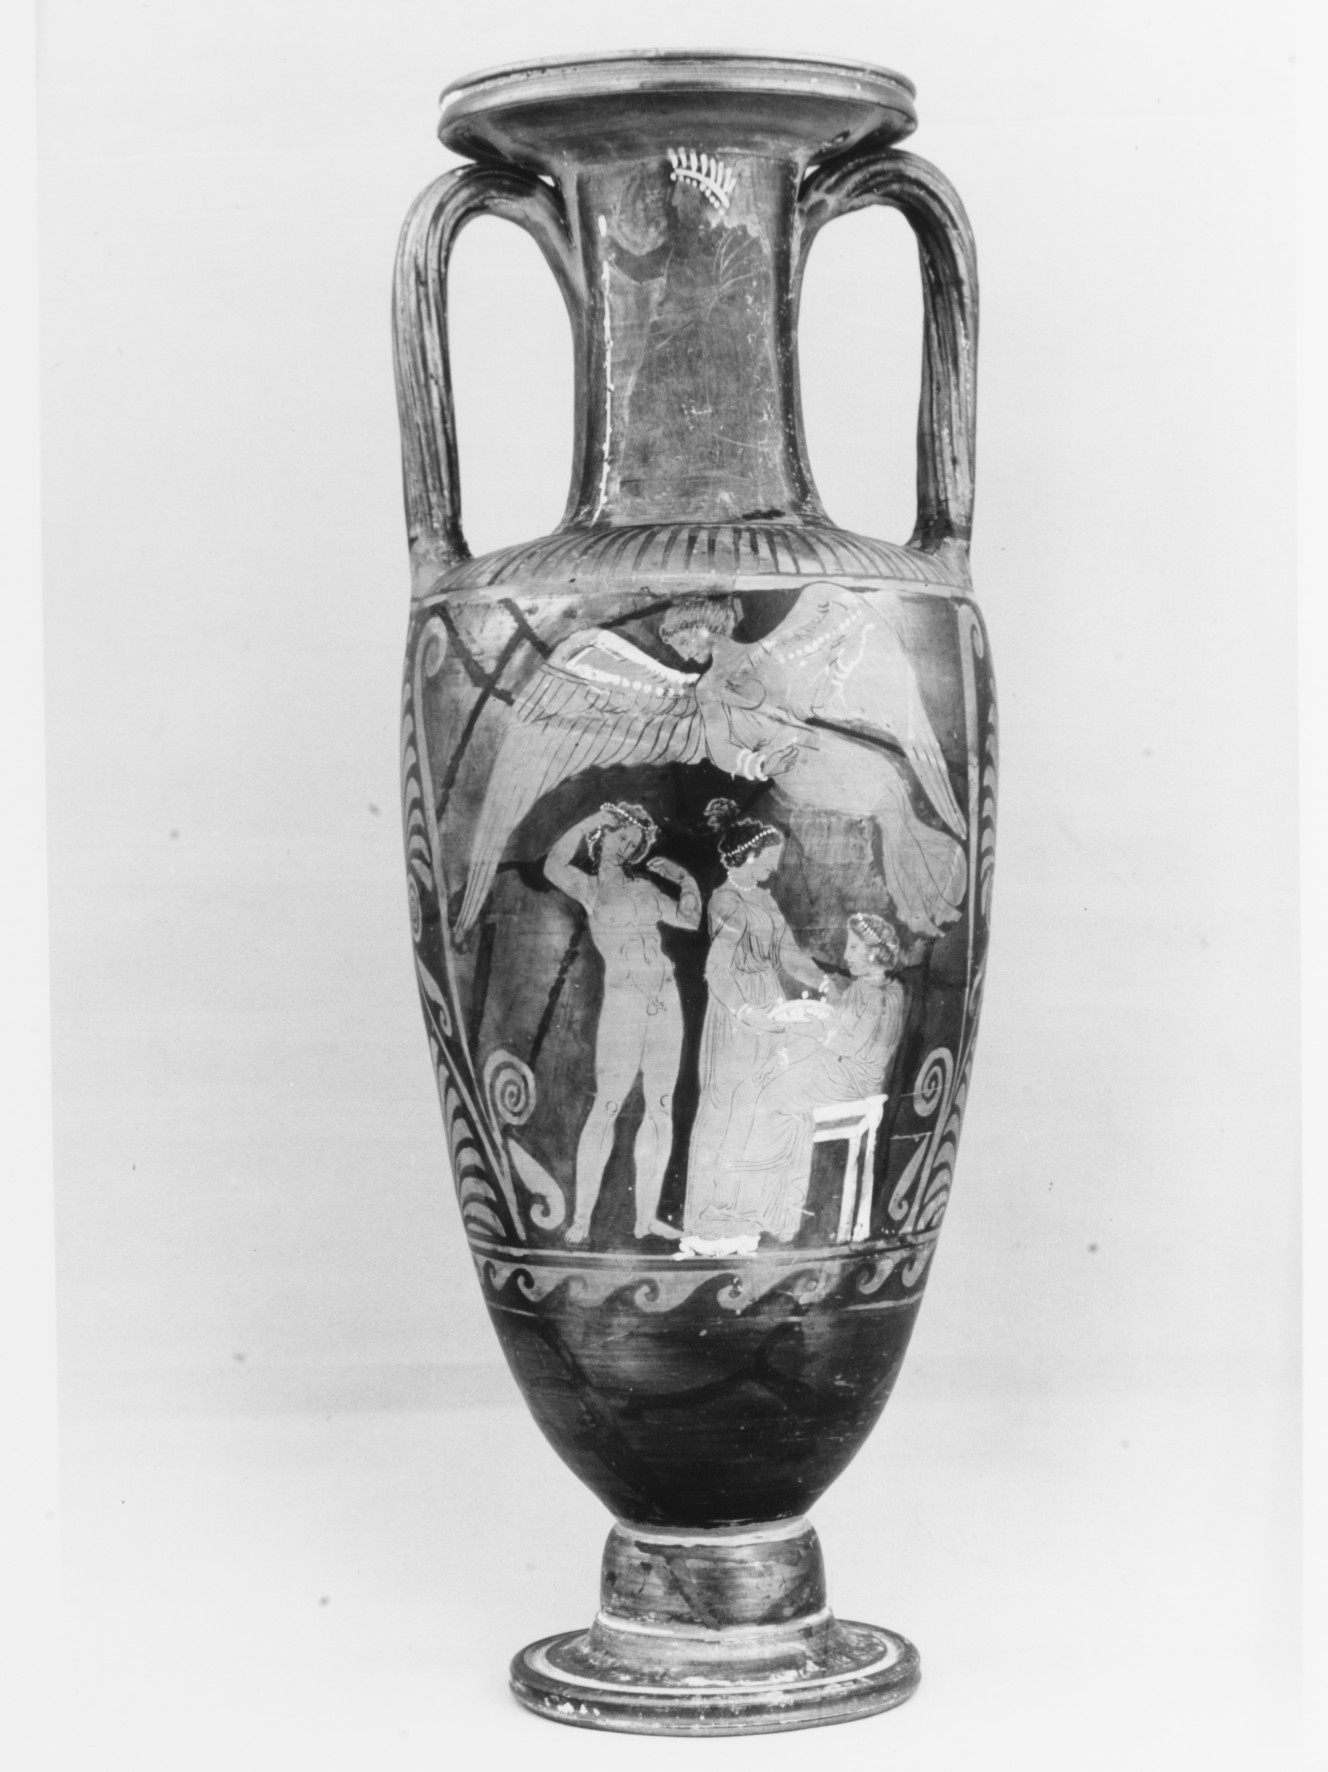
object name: neck amphora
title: Terracotta neck-amphora (jar)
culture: greek or south italian or campanian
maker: ixion painter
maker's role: artist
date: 330-310 BCE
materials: terracotta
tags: male nudes,women